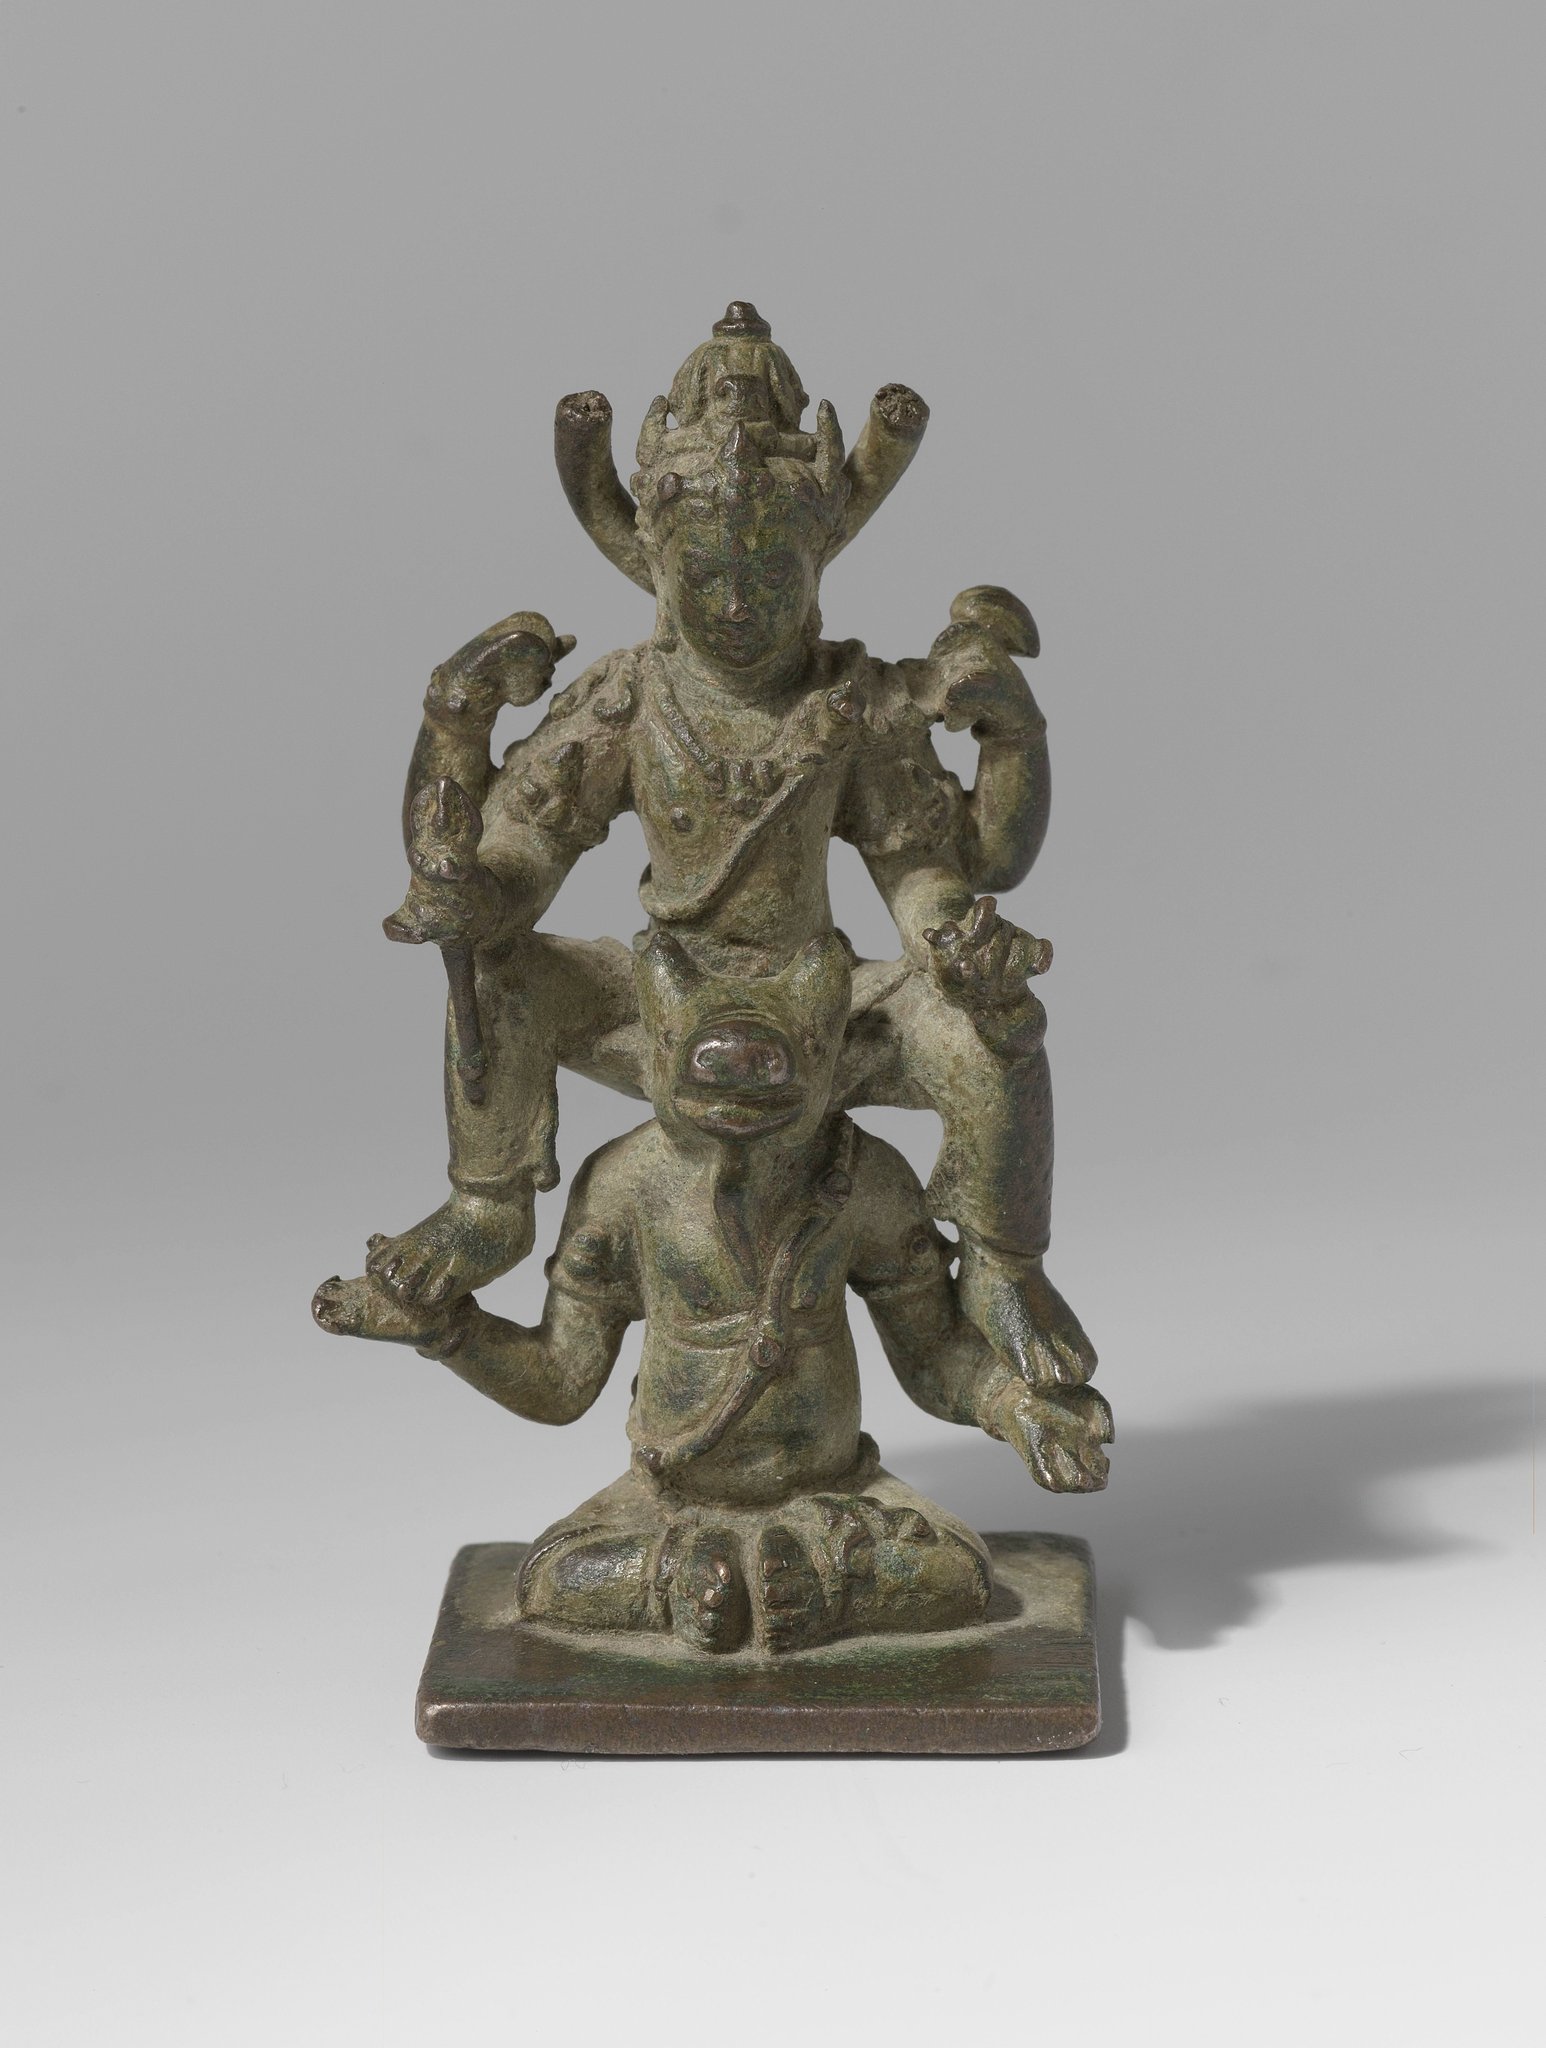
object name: figure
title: Shiva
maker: Anonymous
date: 850-900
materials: bronze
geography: central java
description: Hindu religion and mythology feature elements of the animal world. The Hindu god Shiva is often depicted riding on a bull, but is here shown supported by a seated figure with a bull’s head. Animal strength is also apparent in images of Ganesha, the elephant-headed son of Shiva, who is worshipped as the remover of obstacles.